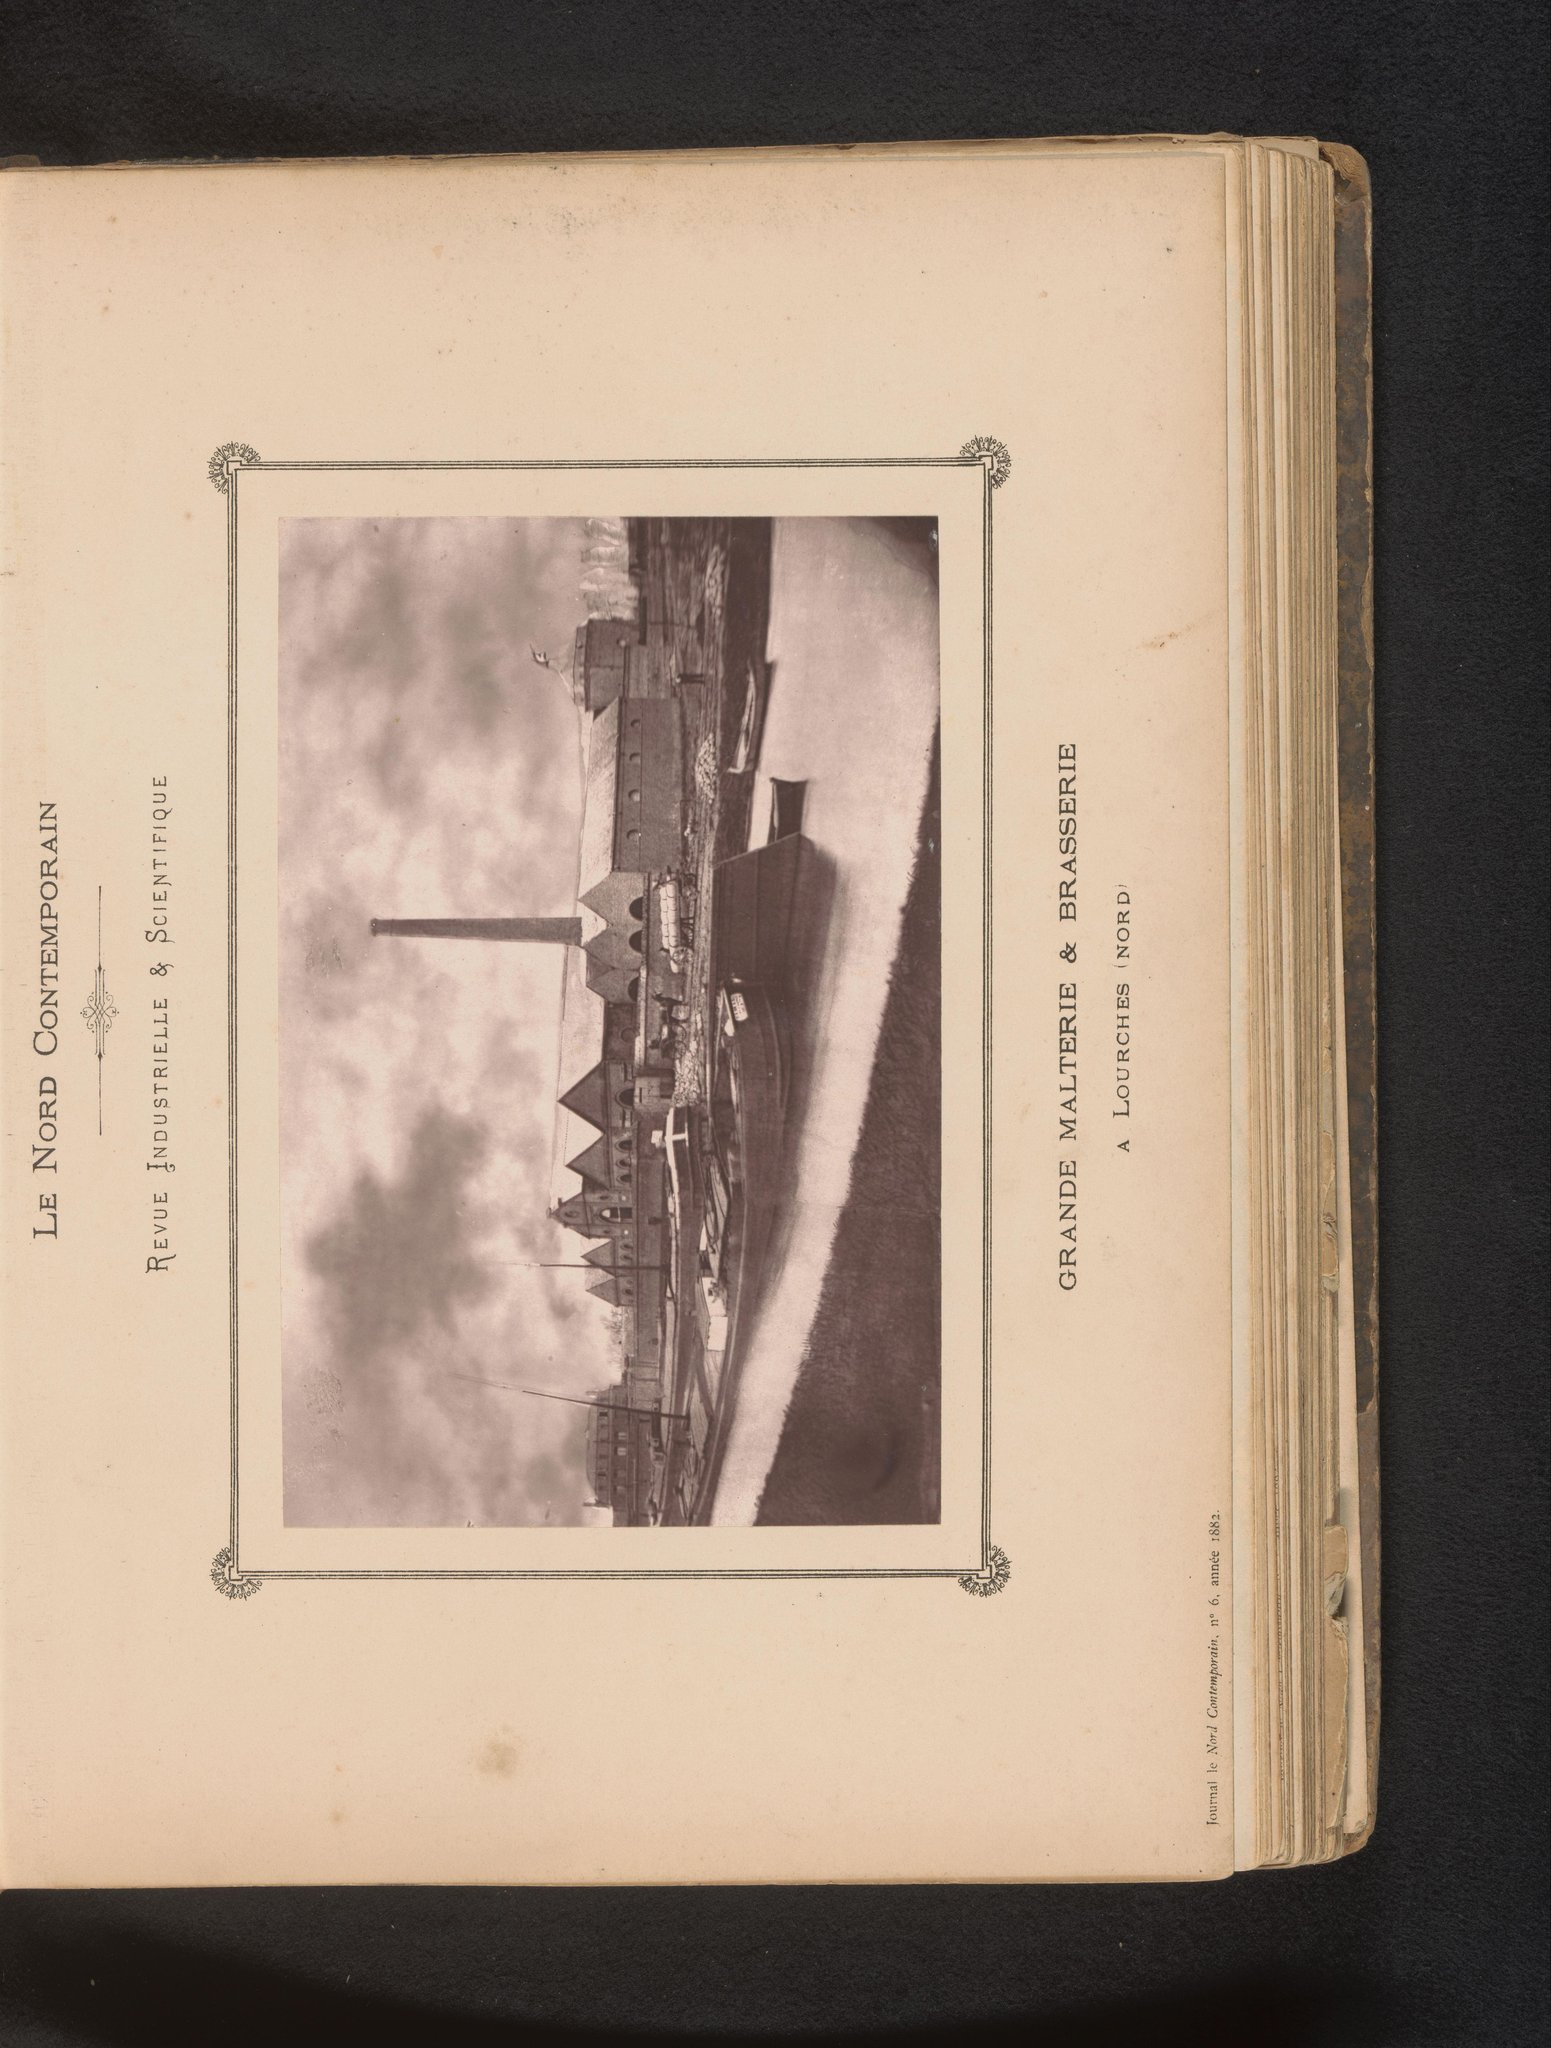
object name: photomechanical print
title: Gezicht op een brouwerij en de Schelde te Lourches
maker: Anonymous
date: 1878-1882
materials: paper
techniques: woodburytype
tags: brewer, canal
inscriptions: inscription: ‘Le Nord Contemporain/ Revue Industrielle & Scientifique’, inscription: ‘Journal le Nord Contemporain, No 6, année 1882’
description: Prent op vijfde ongenummerde pagina na pagina 96.